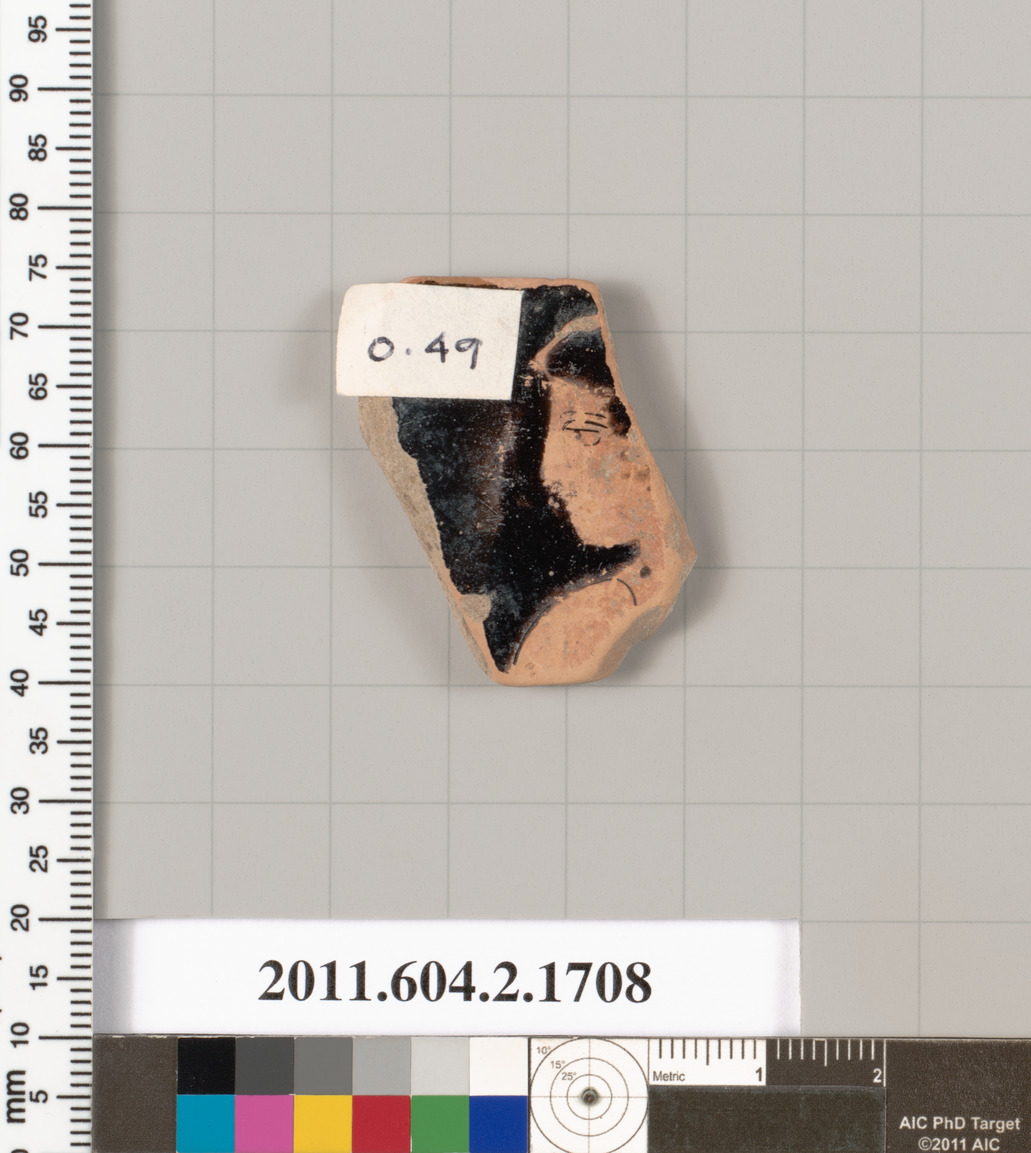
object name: skyphos fragment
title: Terracotta rim fragment of a skyphos (deep drinking cup)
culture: greek, attic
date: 460-440 BCE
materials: terracotta